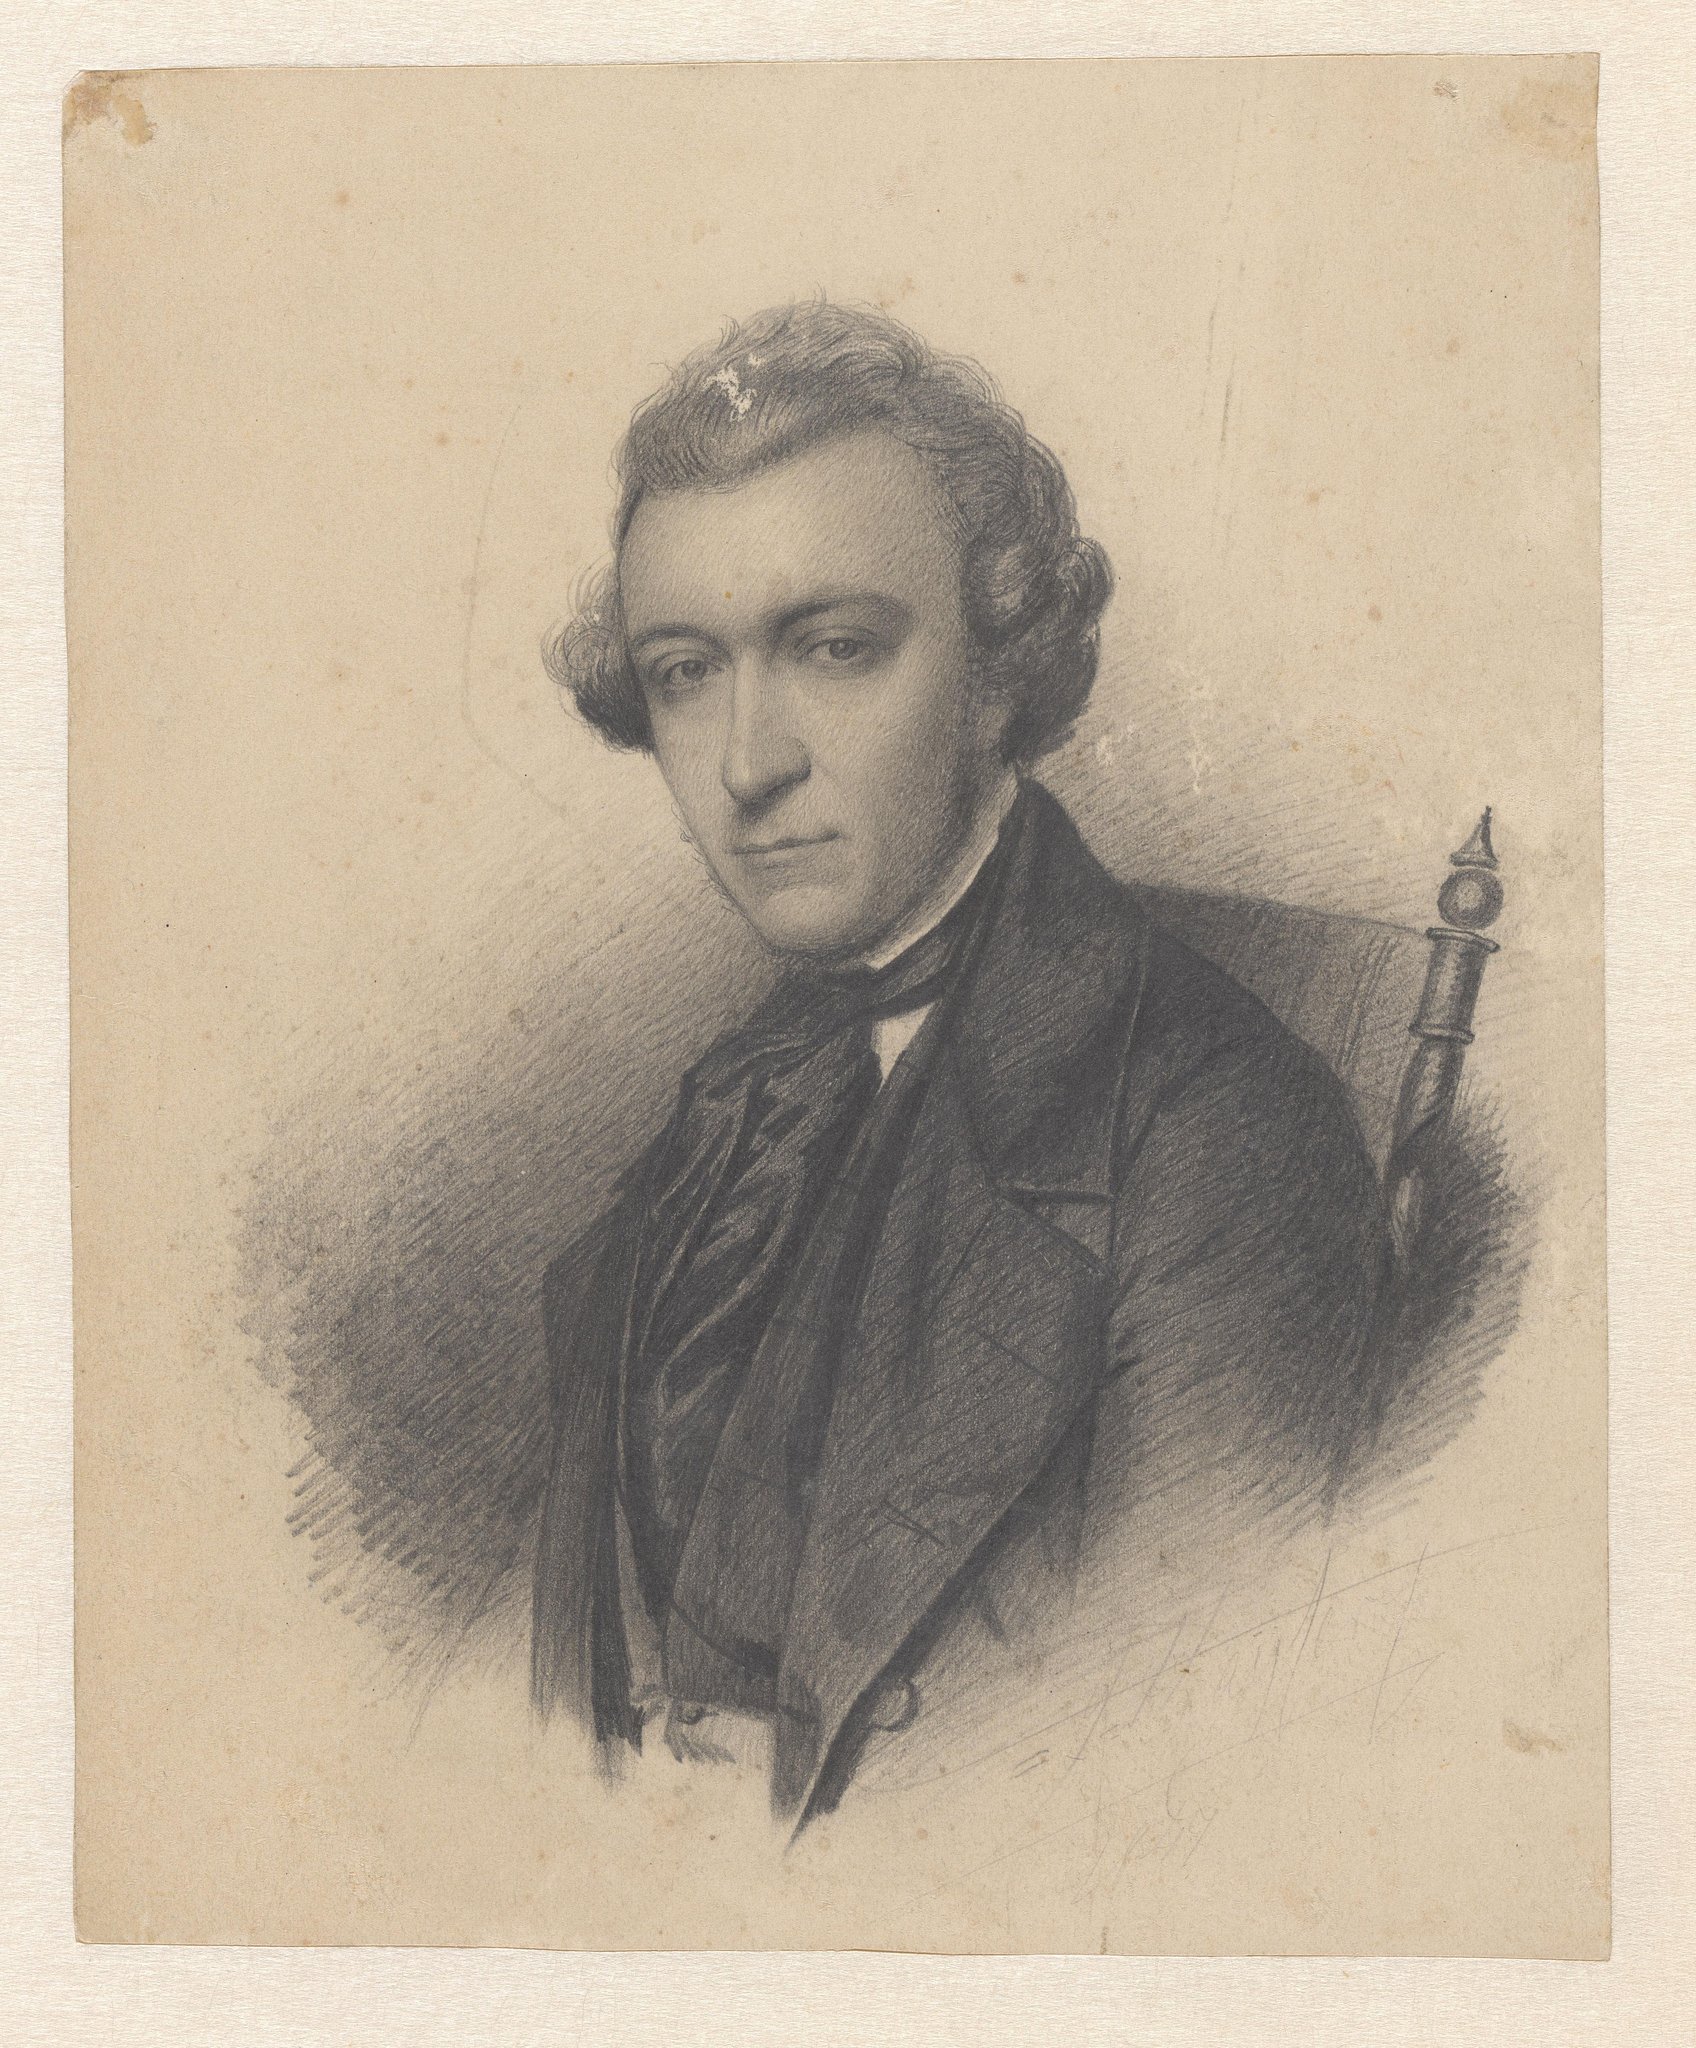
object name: drawing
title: Portret van Joseph Alberdingk Thijm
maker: joseph kayser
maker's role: draughtsman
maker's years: 1803-1900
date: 1847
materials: paper, pencil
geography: amsterdam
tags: painter, draughtsman, publisher, josephus albertus alberdingk thijm, portrait of a writer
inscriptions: inscription: ‘Mr. J.A. Alberdingk Thijm / homme d'lettres / Amsterdam [...] (doorgehaald)’, signature: ‘J. Kaijser f / 1847’, inscription: ‘29.’